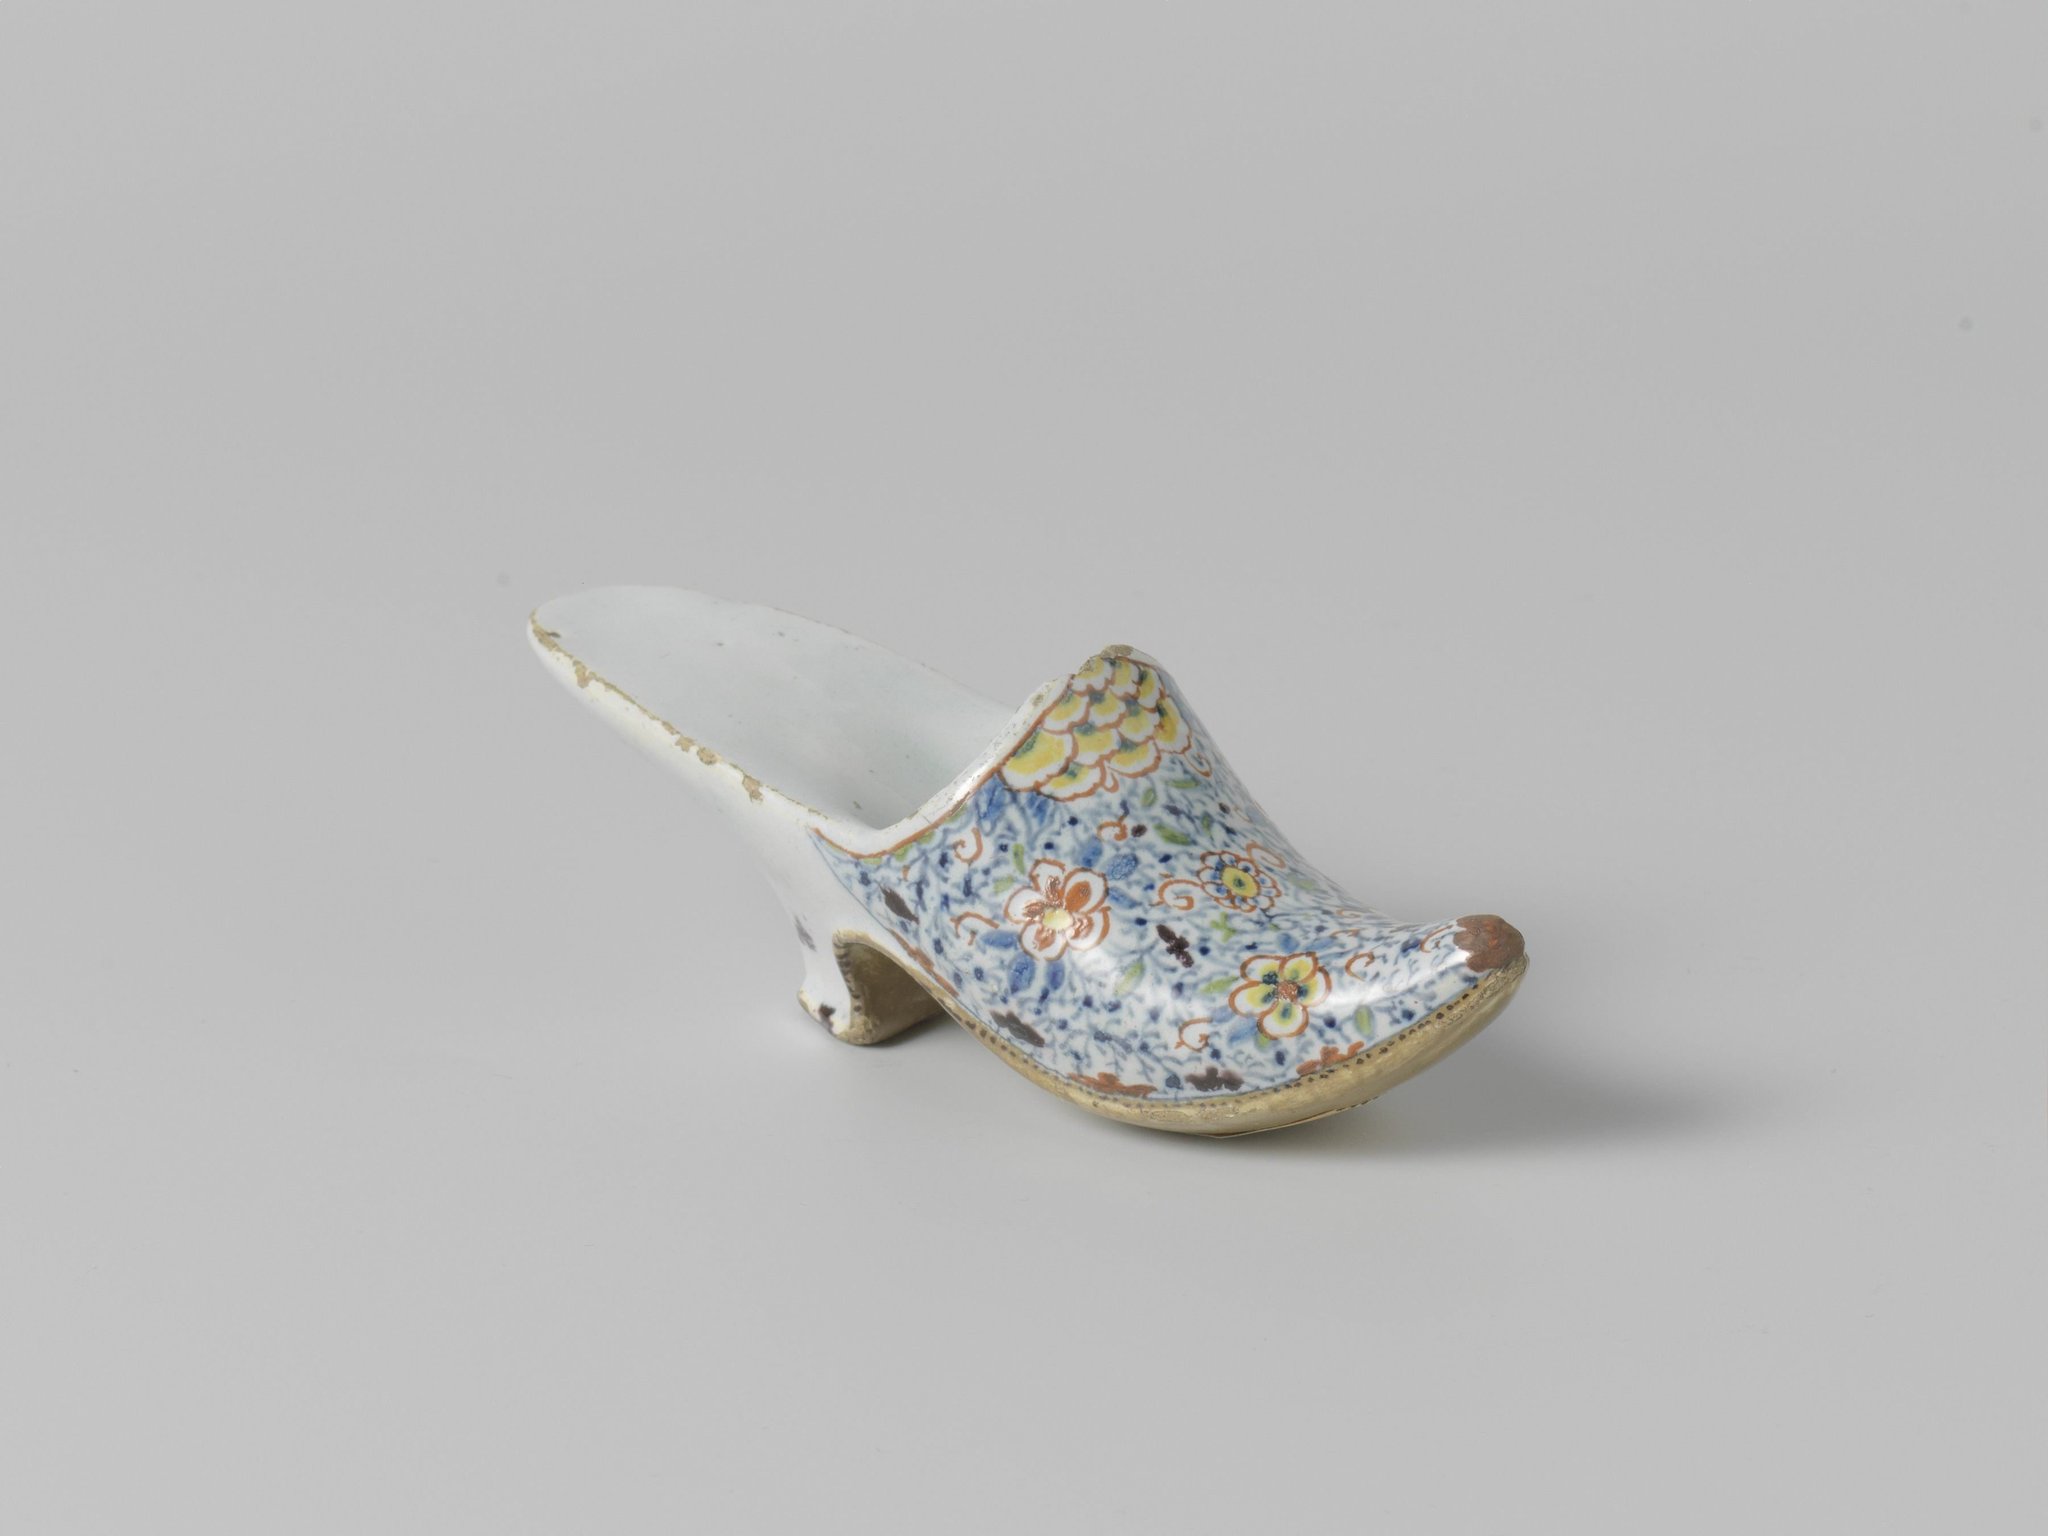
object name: decoratief object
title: Muiltje van faïence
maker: Anonymous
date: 1750-1780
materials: faience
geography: delft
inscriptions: collector's mark: ‘collection JF Loudon’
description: Muiltje van faïence. Veelkleurig beschilderd met bloemen.